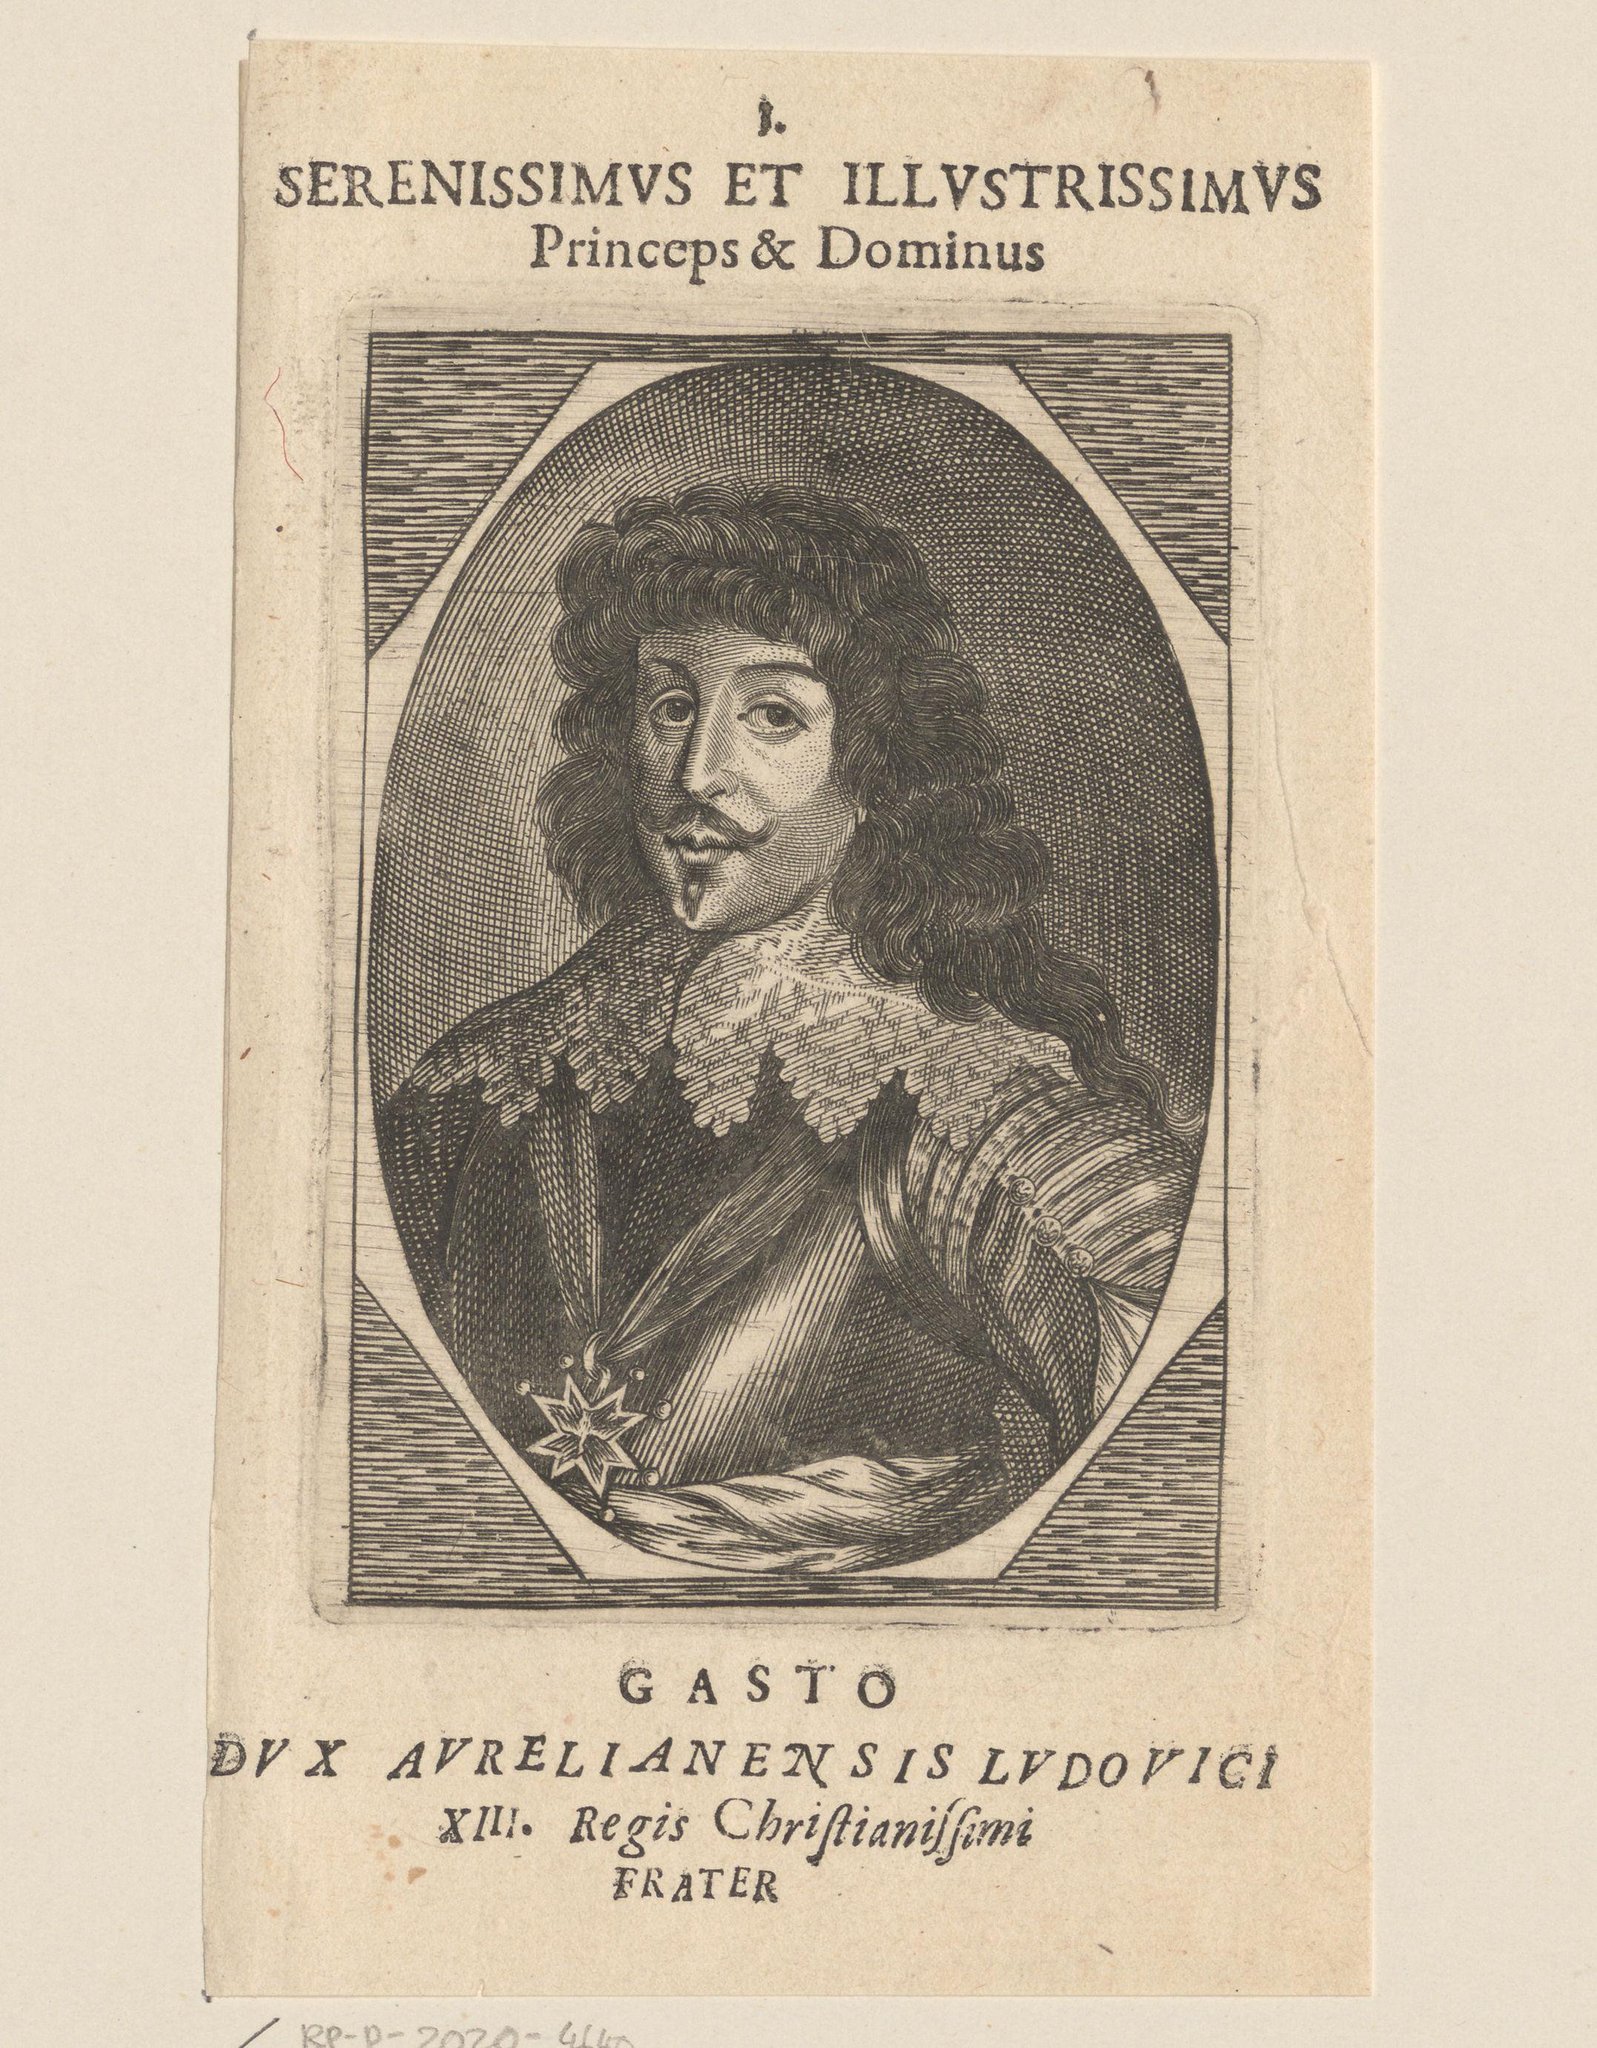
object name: print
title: Serenissimus et Illustrissimus Princeps & Dominus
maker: Anonymous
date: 1627-1630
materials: paper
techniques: engraving, letterpress printing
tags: gaston jean-baptiste hertog van orléans, historical persons